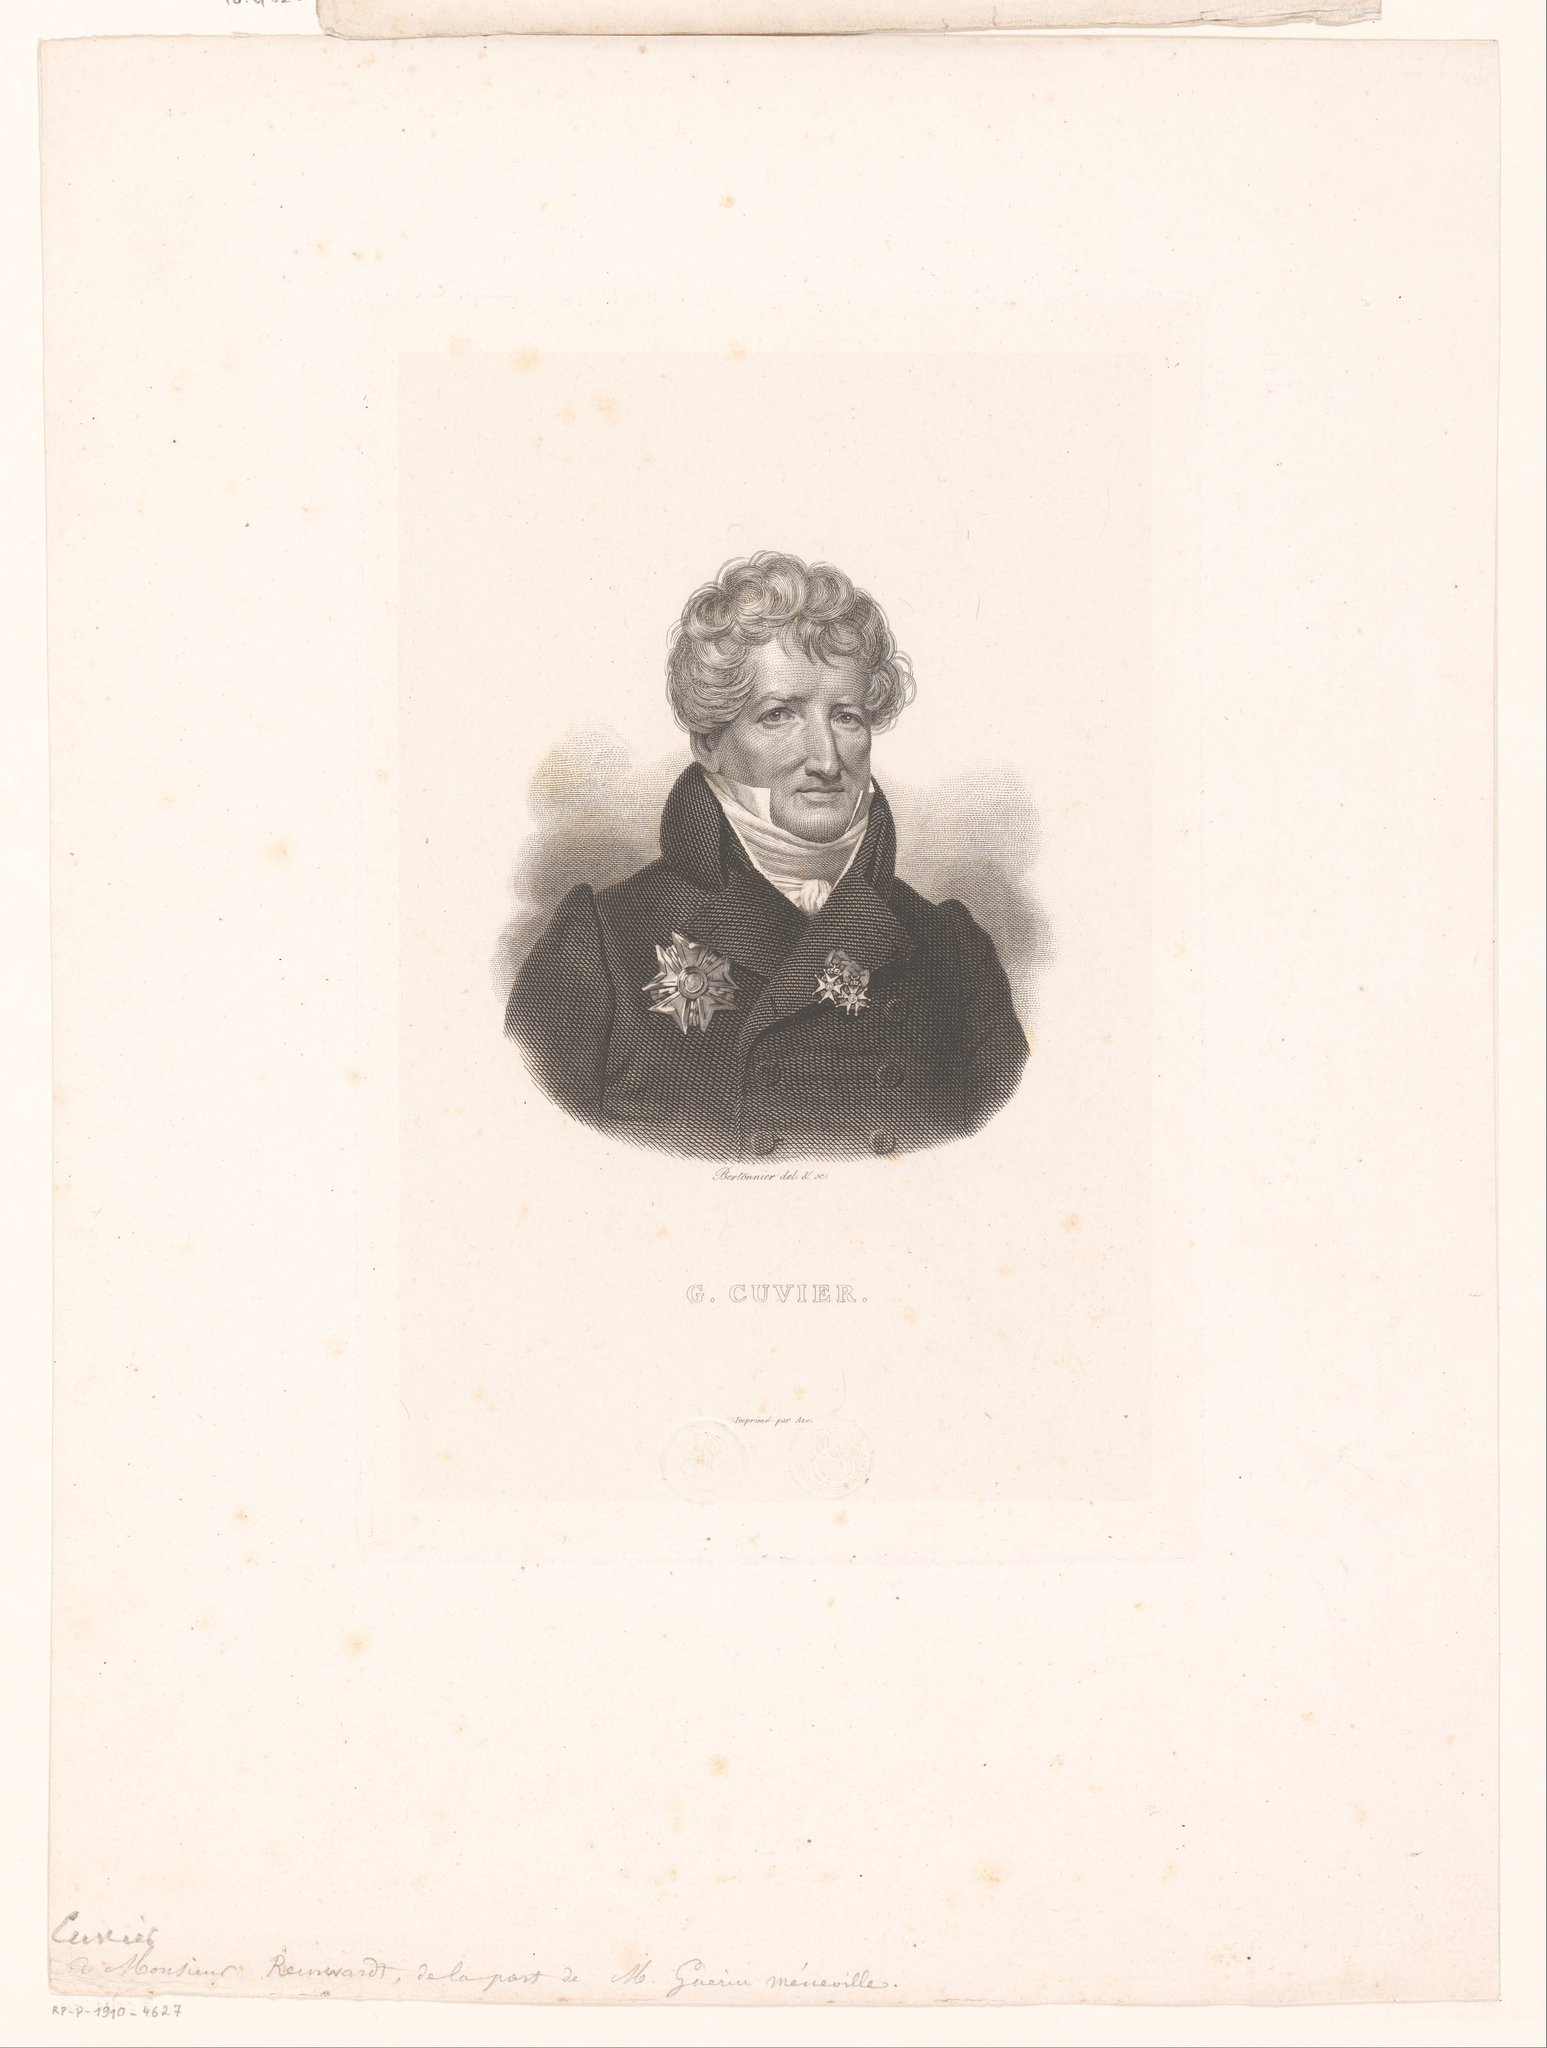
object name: print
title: Portret van Georges Cuvier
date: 1801-1847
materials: paper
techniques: etching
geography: france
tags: paris, historical persons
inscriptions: check stamp, collector's mark: Lugt 2228, check stamp